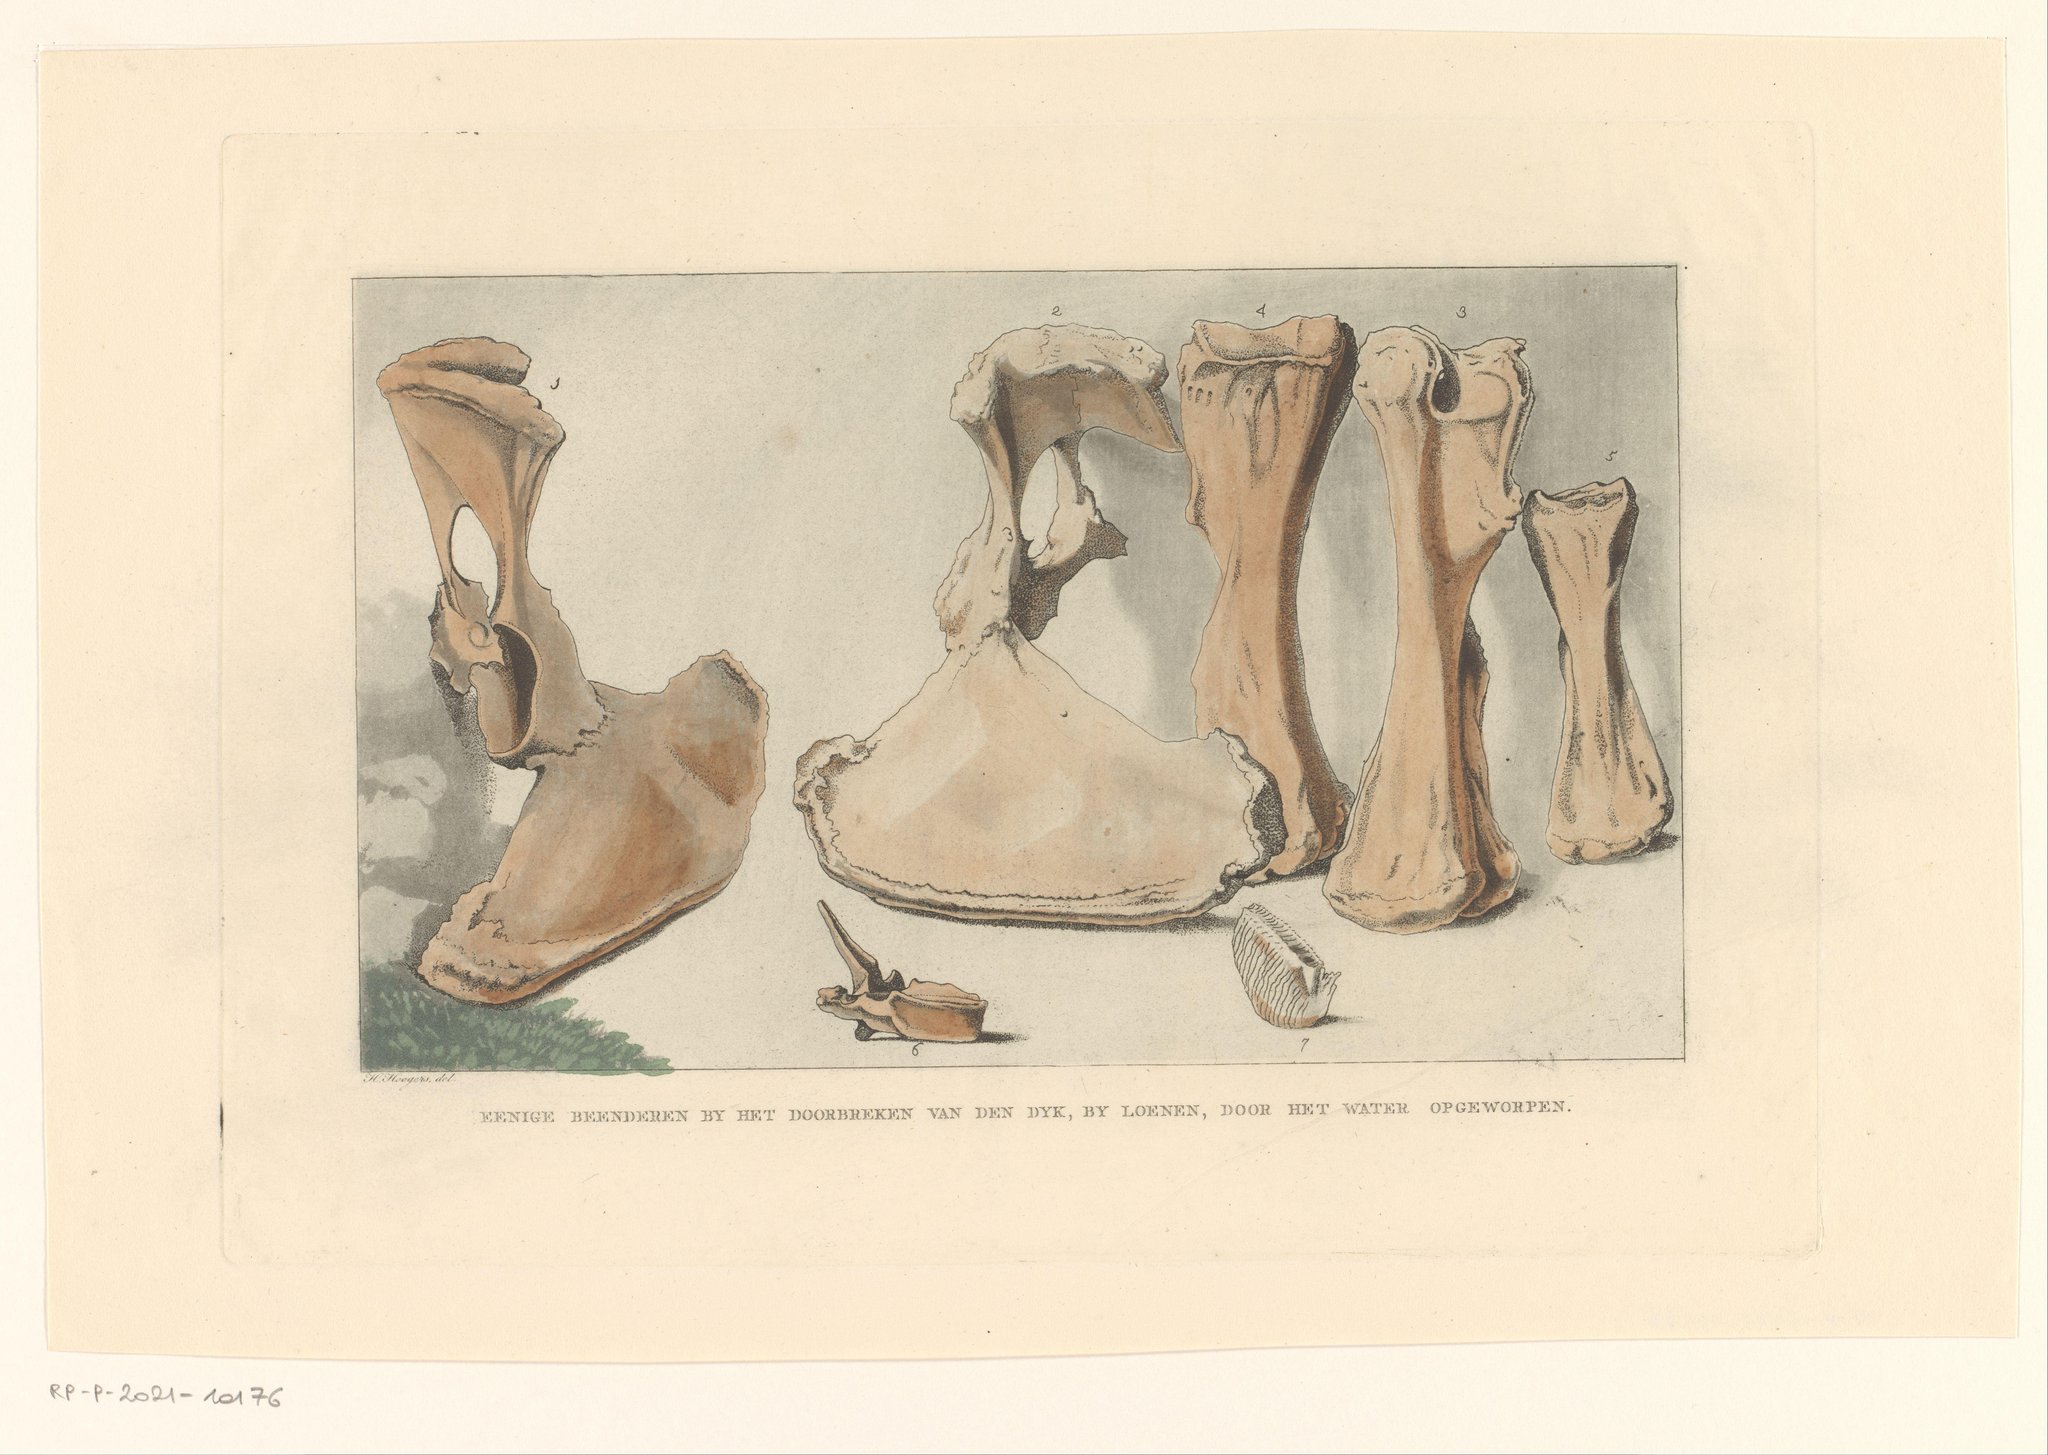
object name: book illustration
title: Fossiele beenderen gevonden tijdens de watersnood bij Loenen, 1809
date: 1809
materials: paper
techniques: aquatint, etching, hand coloring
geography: netherlands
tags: fossil animals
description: Prent waarschijnlijk uit een deel van: Ewijk, Hendrik. Geschiedkundig verslag der dijkbreuken en overstroomingen, langs de rivieren in het Koningrijk Holland, voorgevallen in louwmaand MDCCCIX. 3 dln. Amsterdam: Johannes Allart en Jacobus Ruys, 1809.